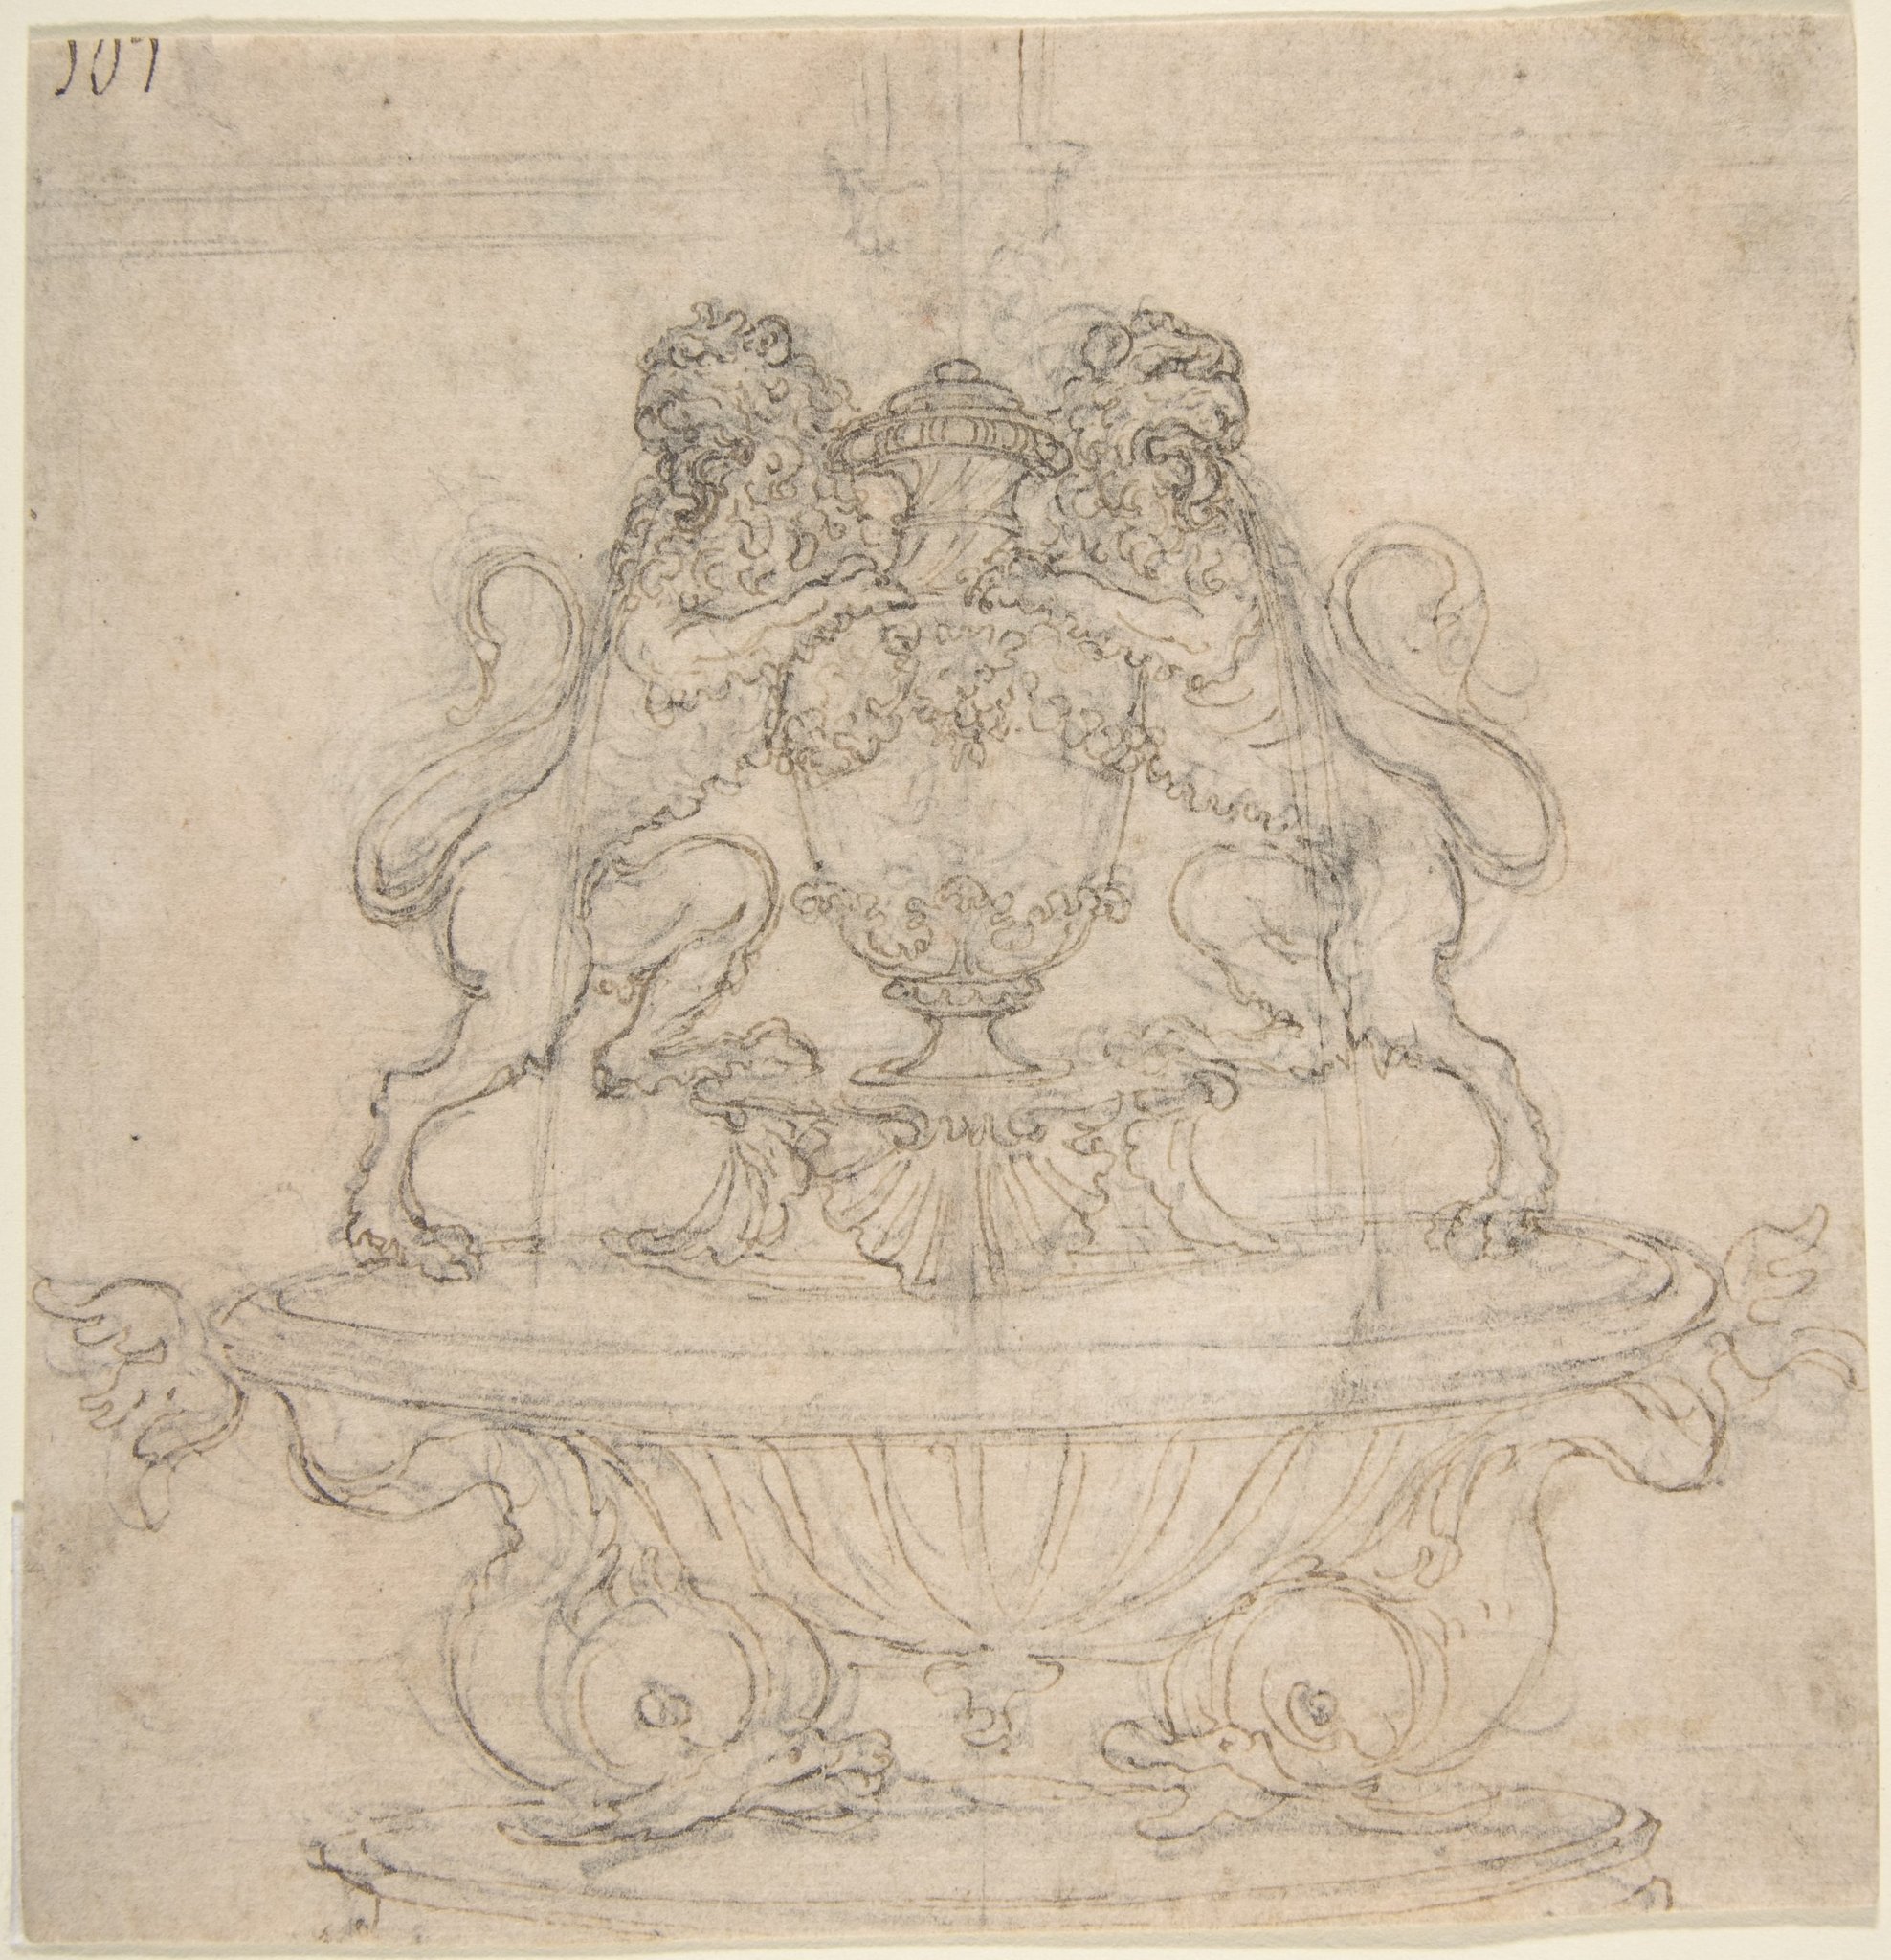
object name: drawing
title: Design for a Fountain with Two Water-Spouting Lions (recto); Sketch for Triumph of Galatea [?] (verso)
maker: giovanni battista foggini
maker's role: artist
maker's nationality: italian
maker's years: 1652-1725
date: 1672-1725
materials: chalk, ink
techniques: pen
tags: fountains,lions